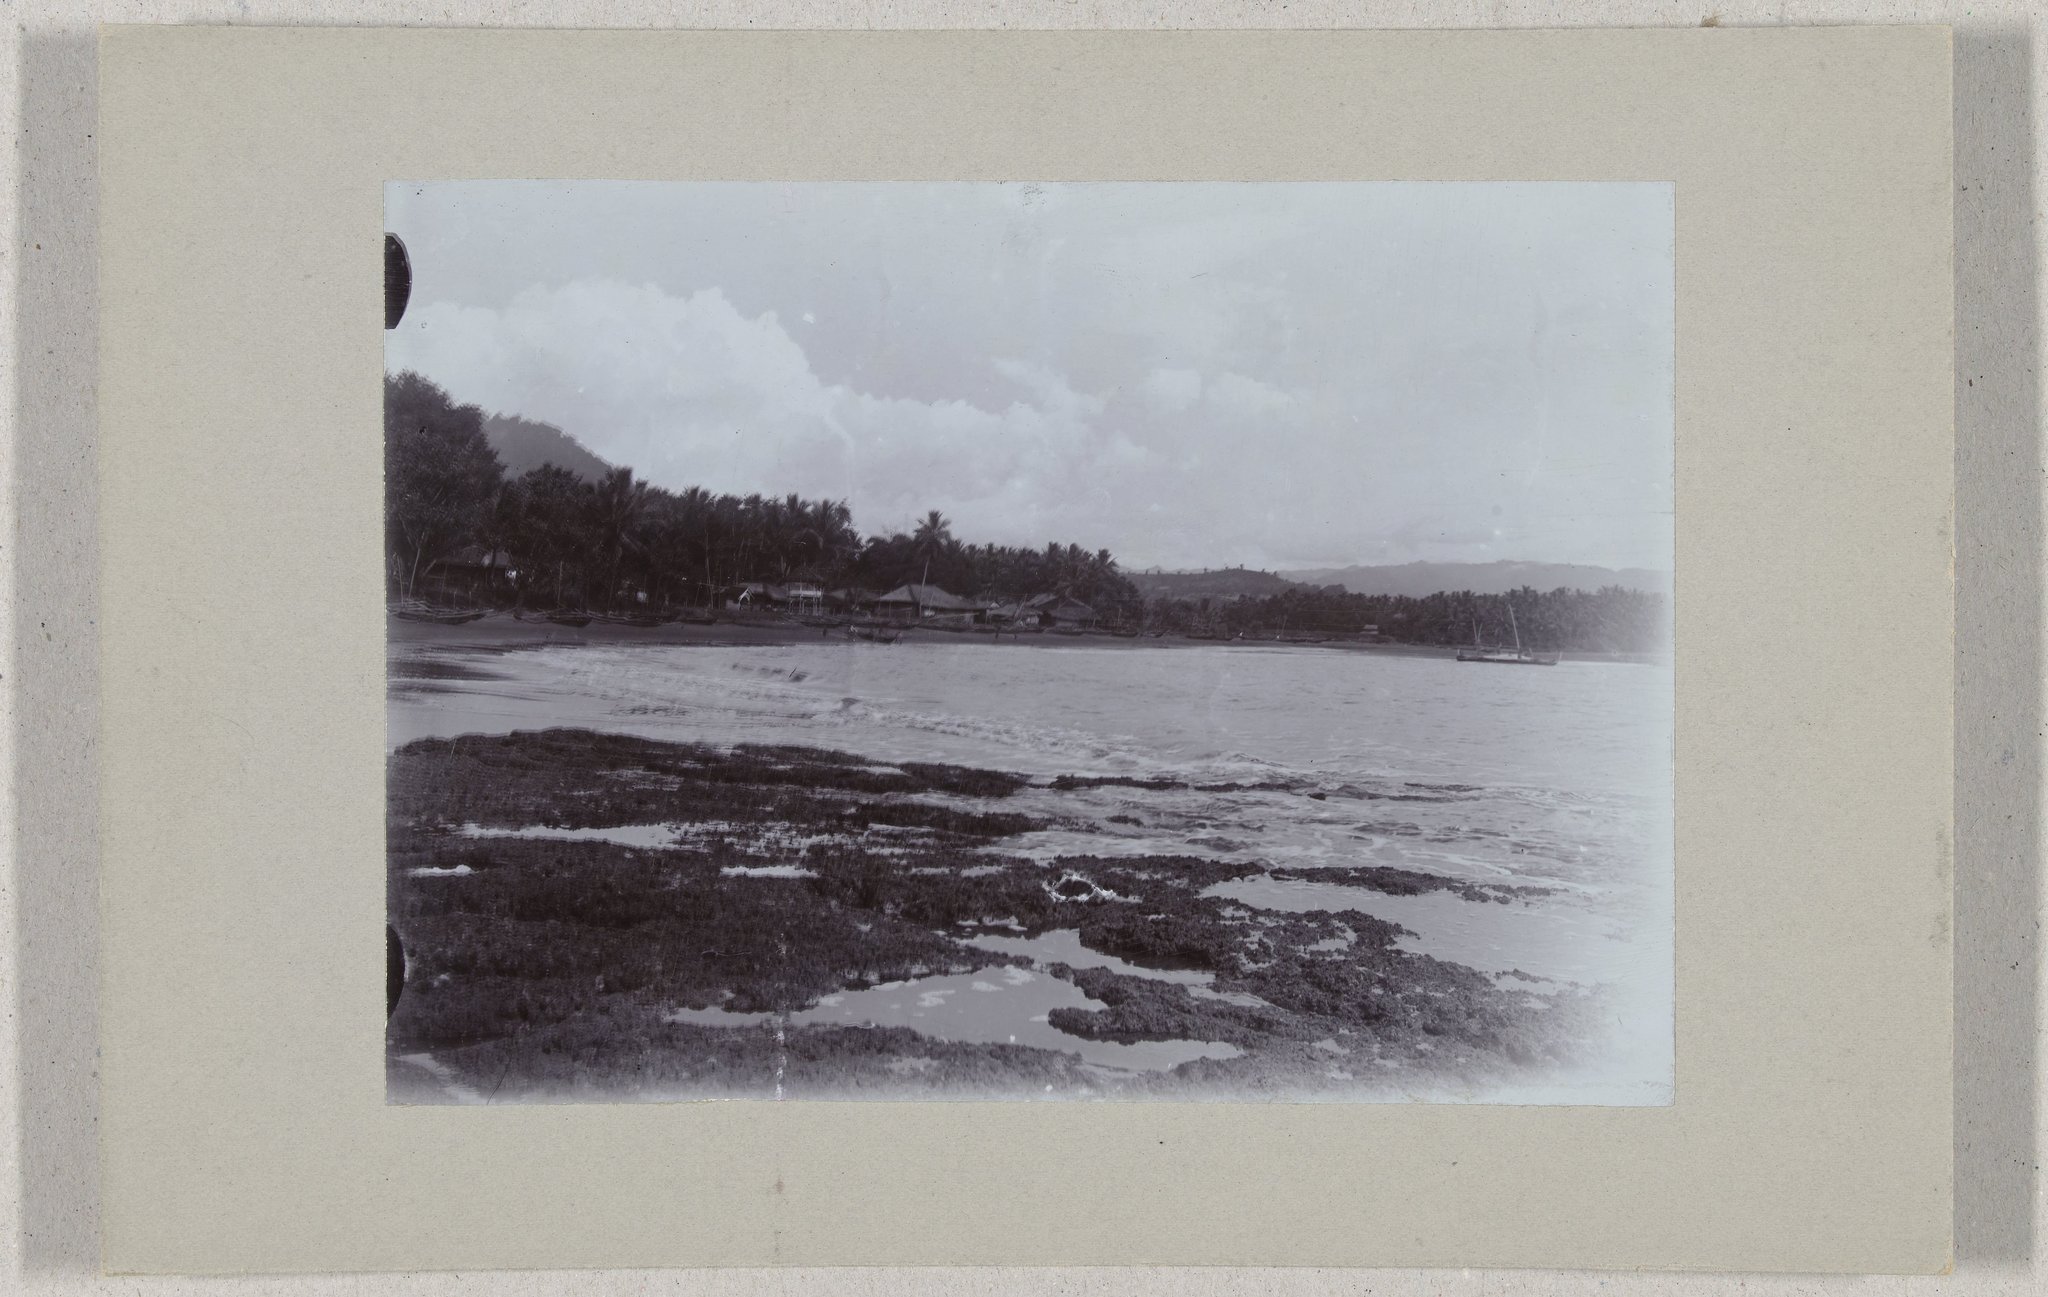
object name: photograph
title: Wijnkoopsbaai in Nederlands-Indië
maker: Anonymous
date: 1895-1915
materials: cardboard, paper, photographic support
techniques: gelatin silver print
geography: dutch east indies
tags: indonesia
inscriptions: annotation: ‘57a Wijnkoopsbaai’